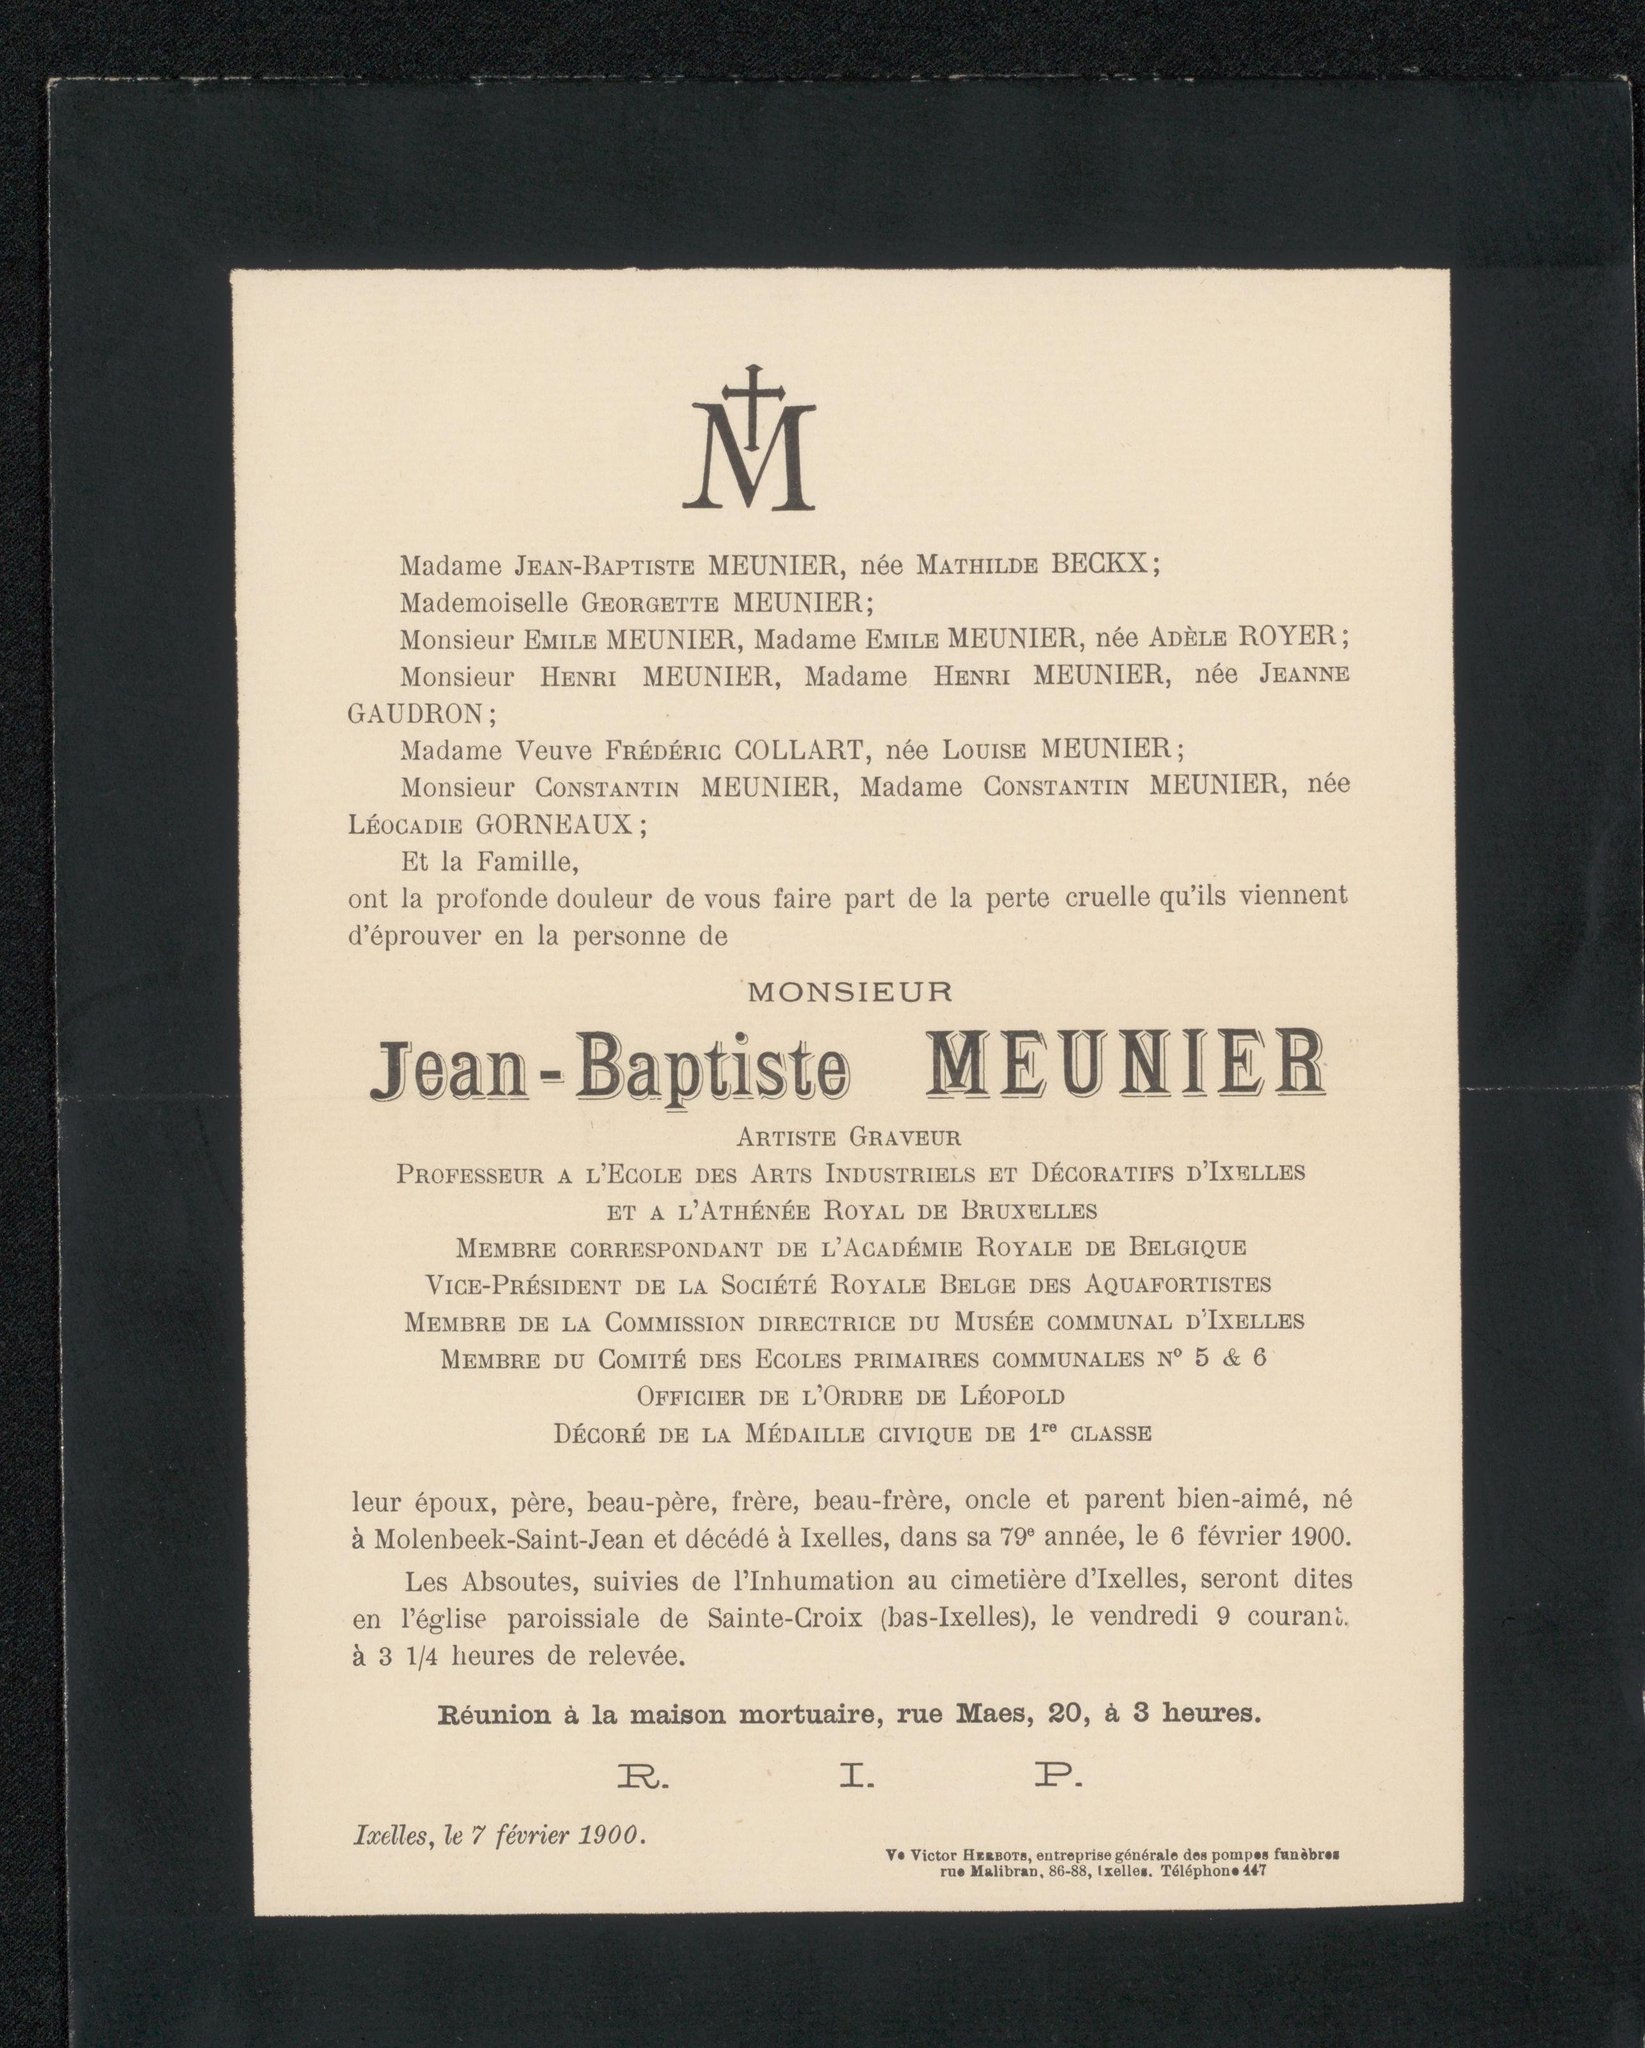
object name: overlijdensbericht, overlijdensadvertentie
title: Overlijdensbericht aan Philip Zilcken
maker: Anonymous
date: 1900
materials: ink, paper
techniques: pen, printing, writing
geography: elsene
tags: print maker, jean-baptiste meunier, the hague, painter, draughtsman, philip zilcken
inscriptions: collector's mark: ‘RPK’